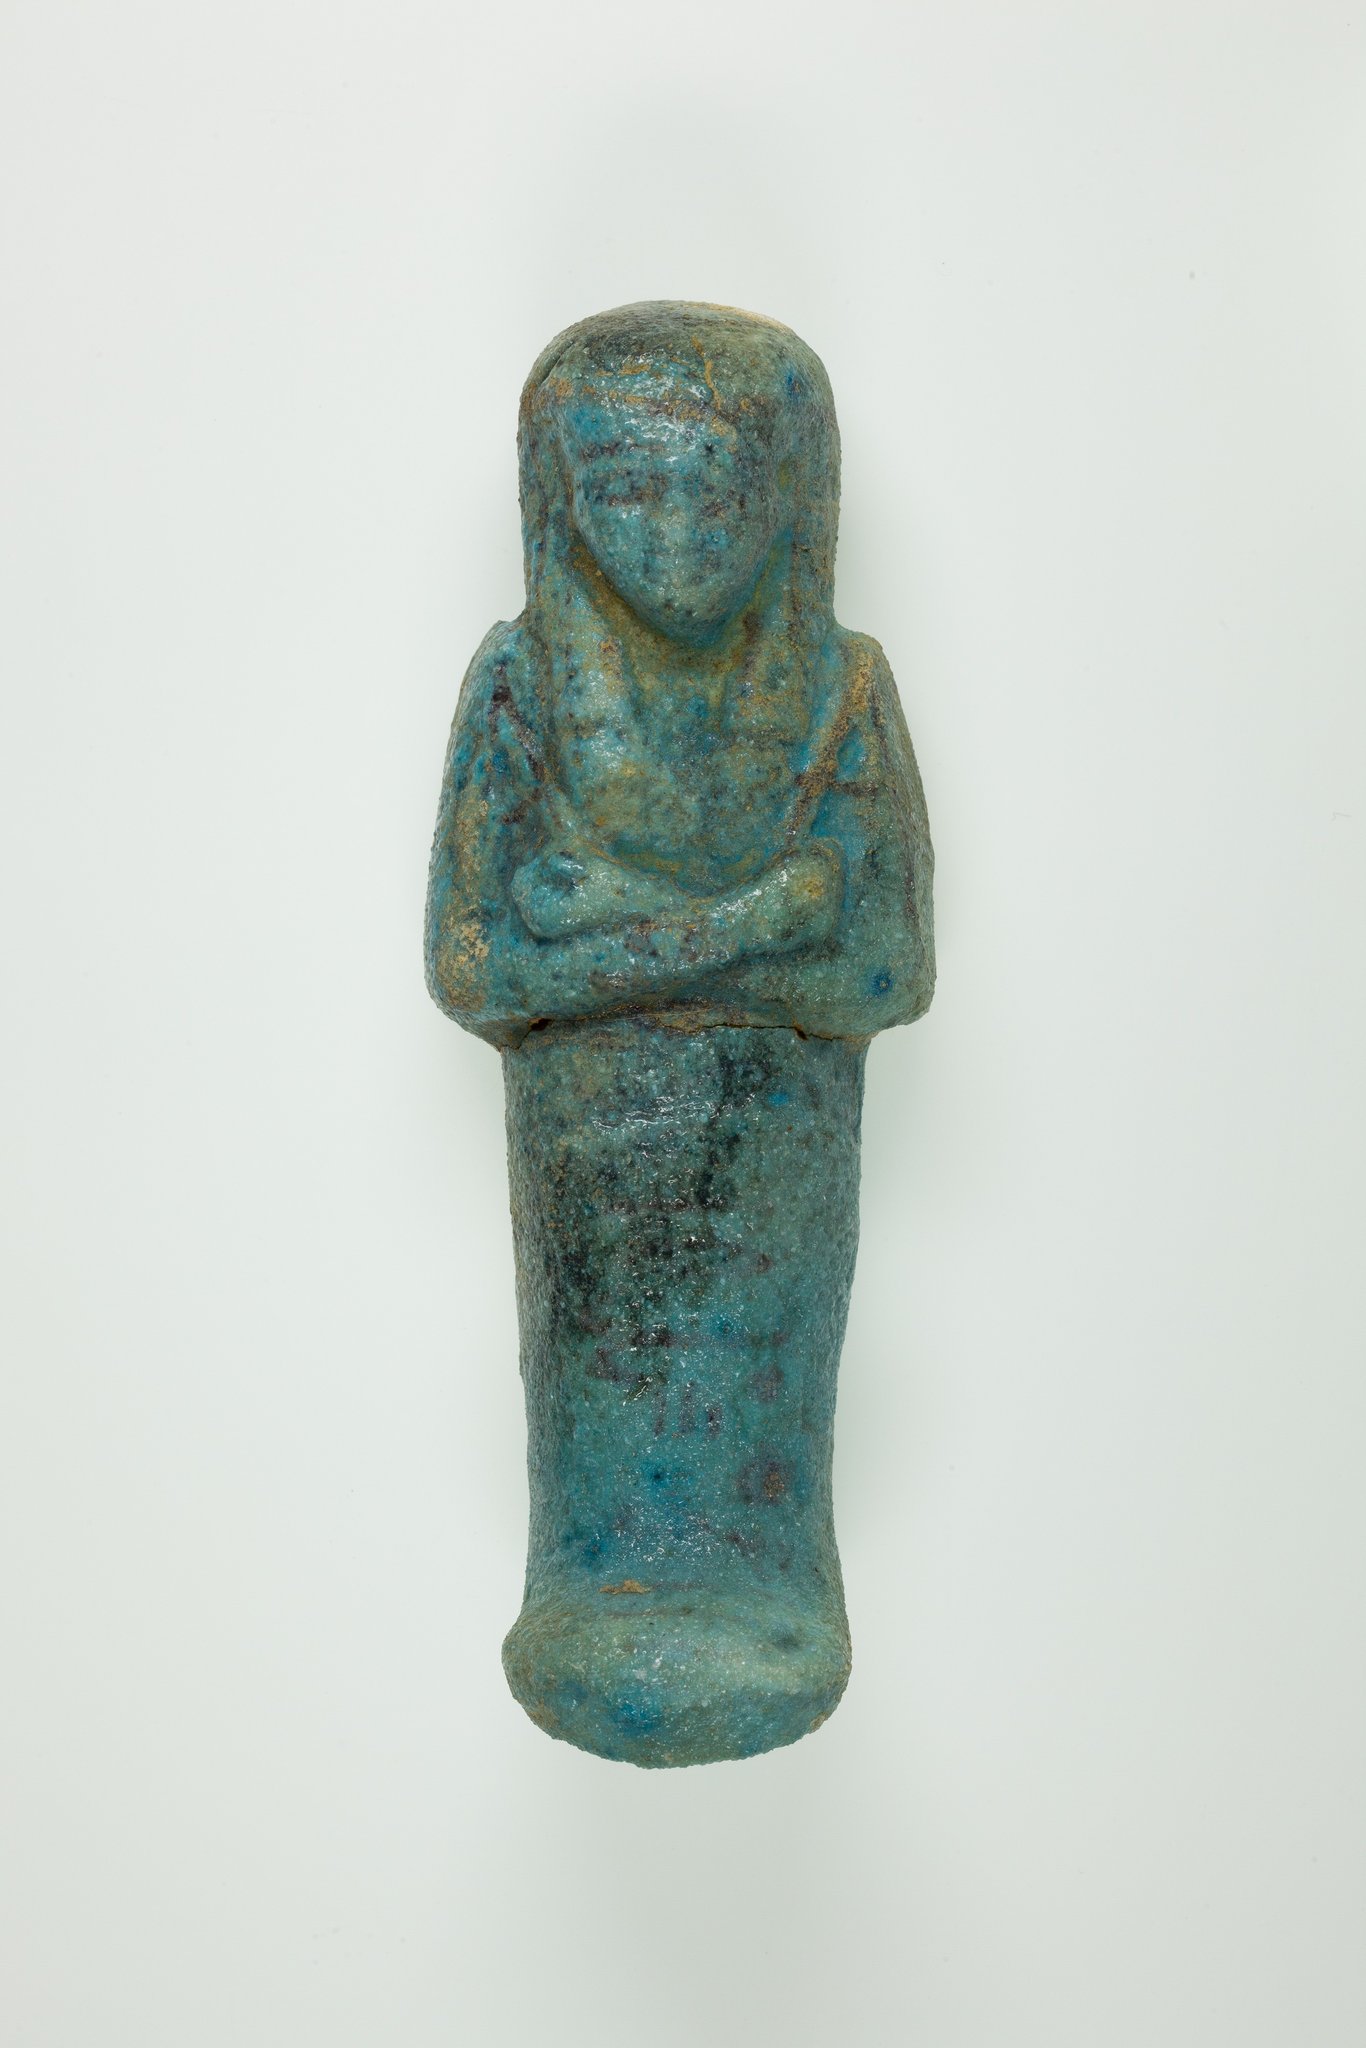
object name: worker shabti, henettawy c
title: Worker Shabti of Henettawy (C), Daughter of Isetemkheb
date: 990-970 BCE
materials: faience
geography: egypt